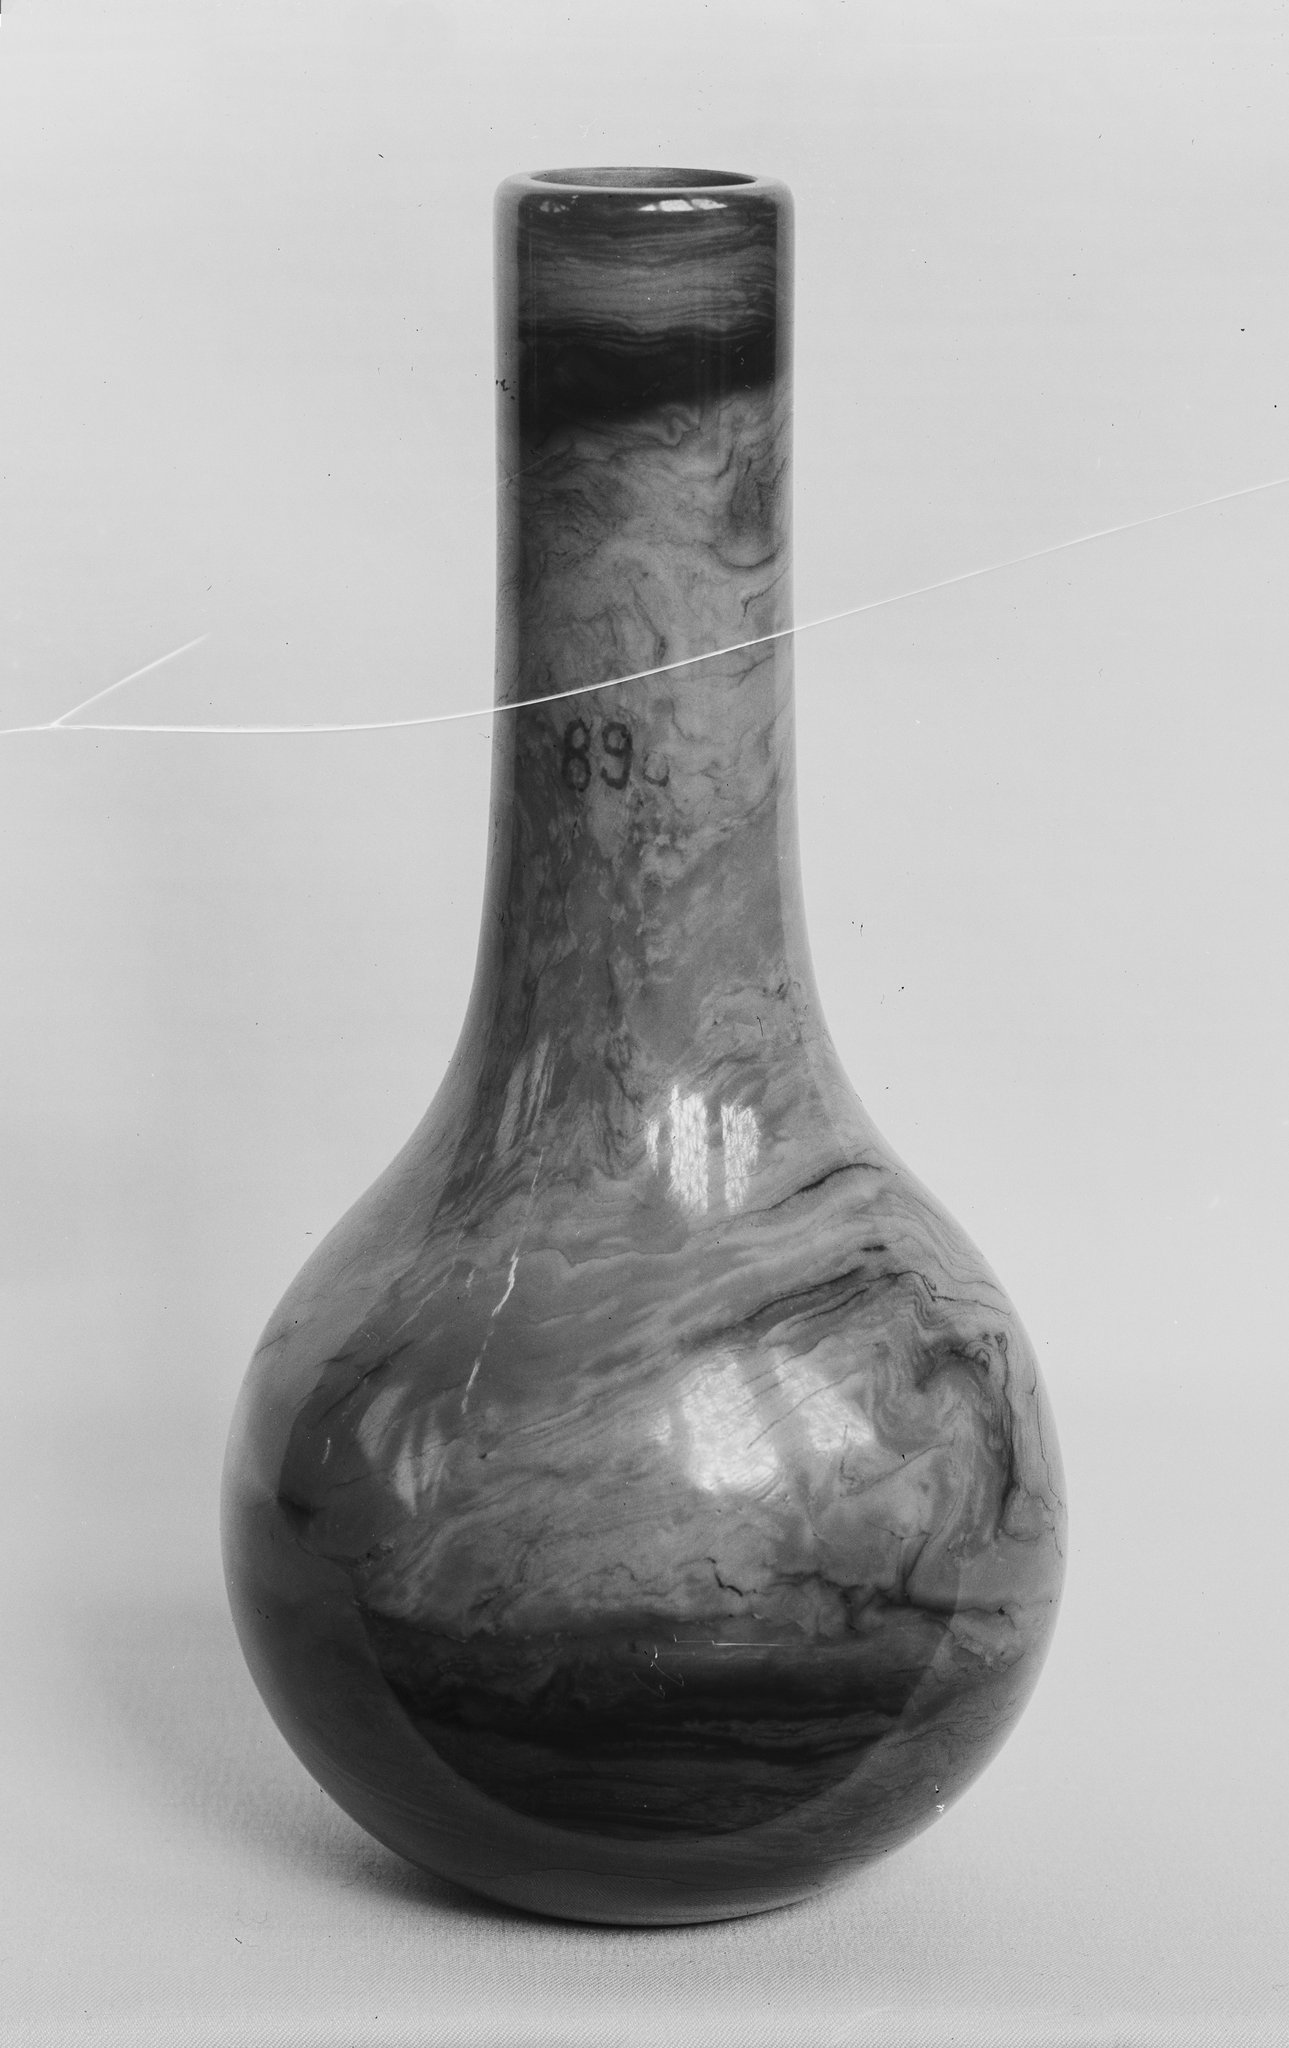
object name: bottle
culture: chinese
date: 1701-1800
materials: stone